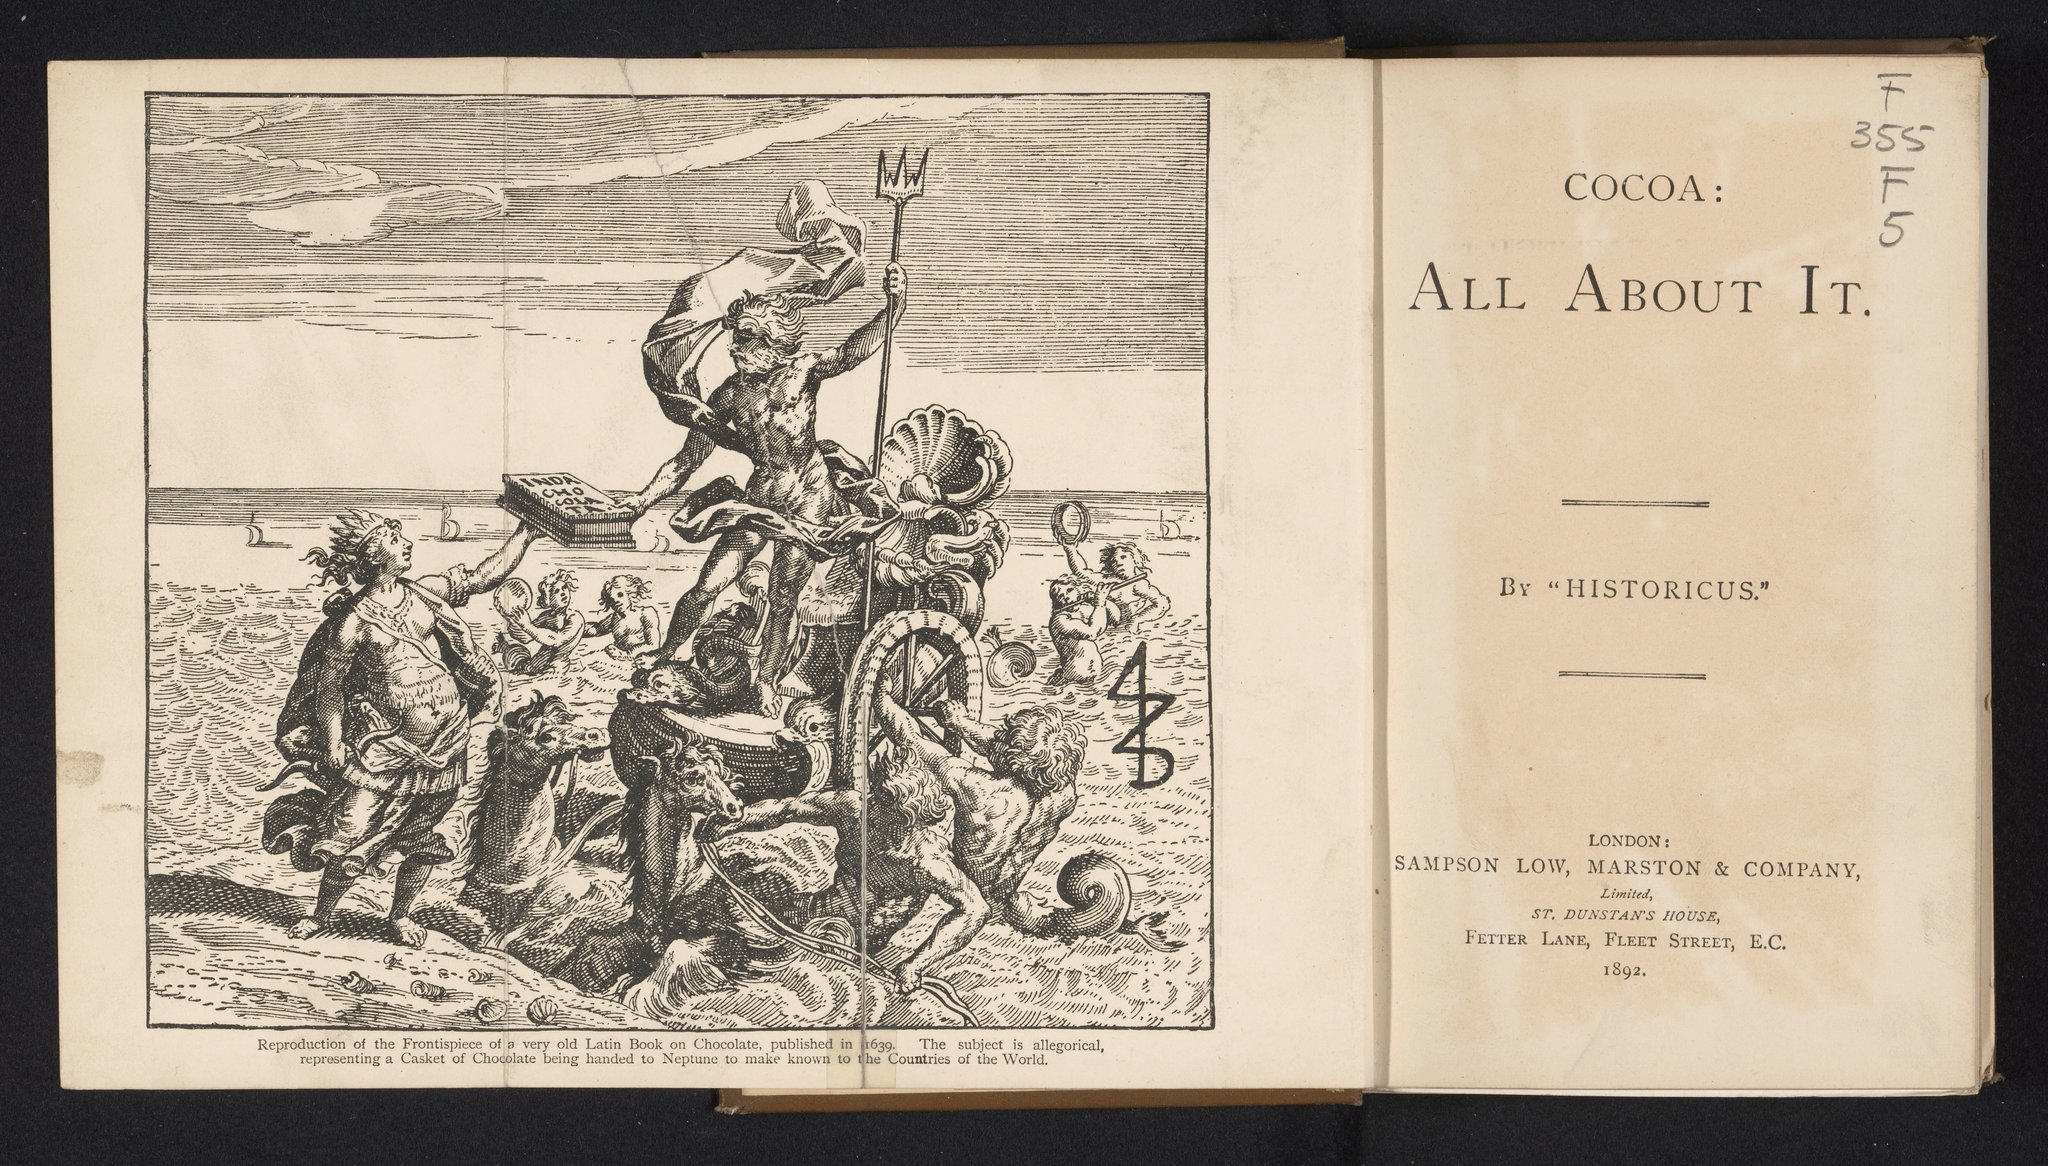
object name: book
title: Cocoa : all about it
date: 1892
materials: cardboard, linen, paper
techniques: photograph, printing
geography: london